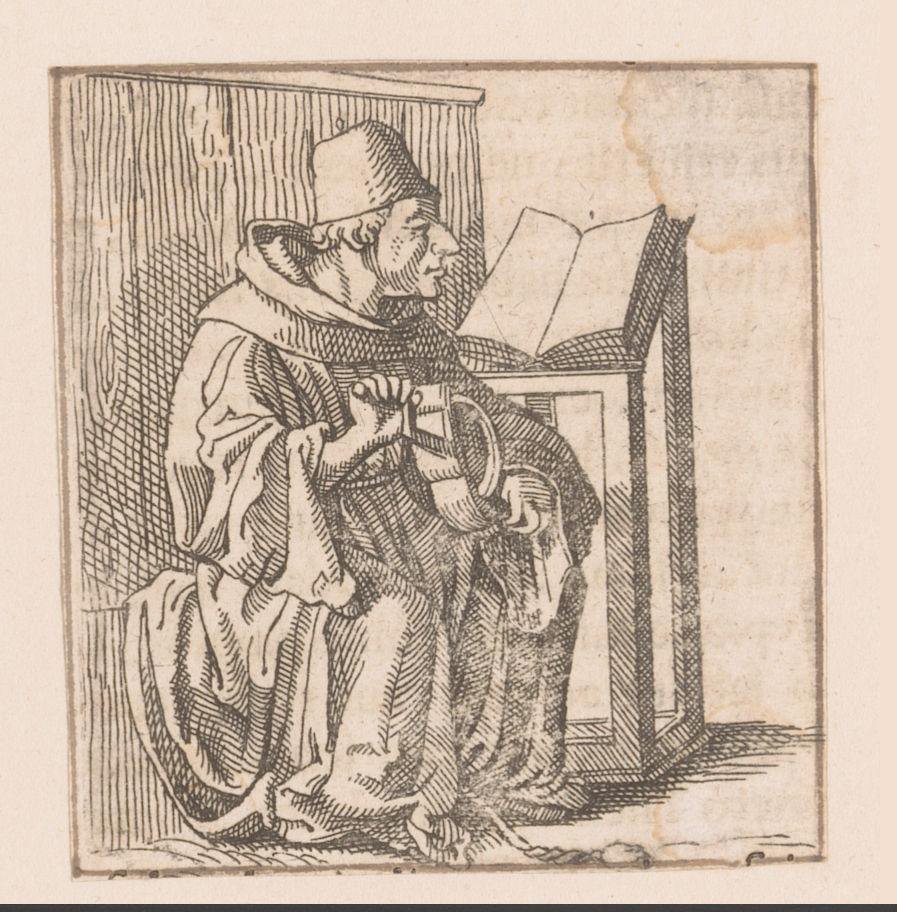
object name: book illustration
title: Heilige Nicolaas van Myra speelt op een lier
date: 1516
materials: paper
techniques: etching, letterpress printing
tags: rotterdam, desiderius erasmus, attributes of apollo: lyre, the bishop nicholas of myra (or bari); possible attributes: anchor, boat, three golden balls (on a book), three purses, three children in a tub, three maidens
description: Prent afkomstig uit: Erasmus, Desiderius. Morias enkomion (...). Bazel: Johann Rudolf Genath, 1676. De prenten hierin zijn naar tekeningen die Hans en Ambrosius Holbein maakten voor de theoloog Oswald Myconius in diens uitgave van de Moriae encomium (Lof der Zotheid) van 1516.